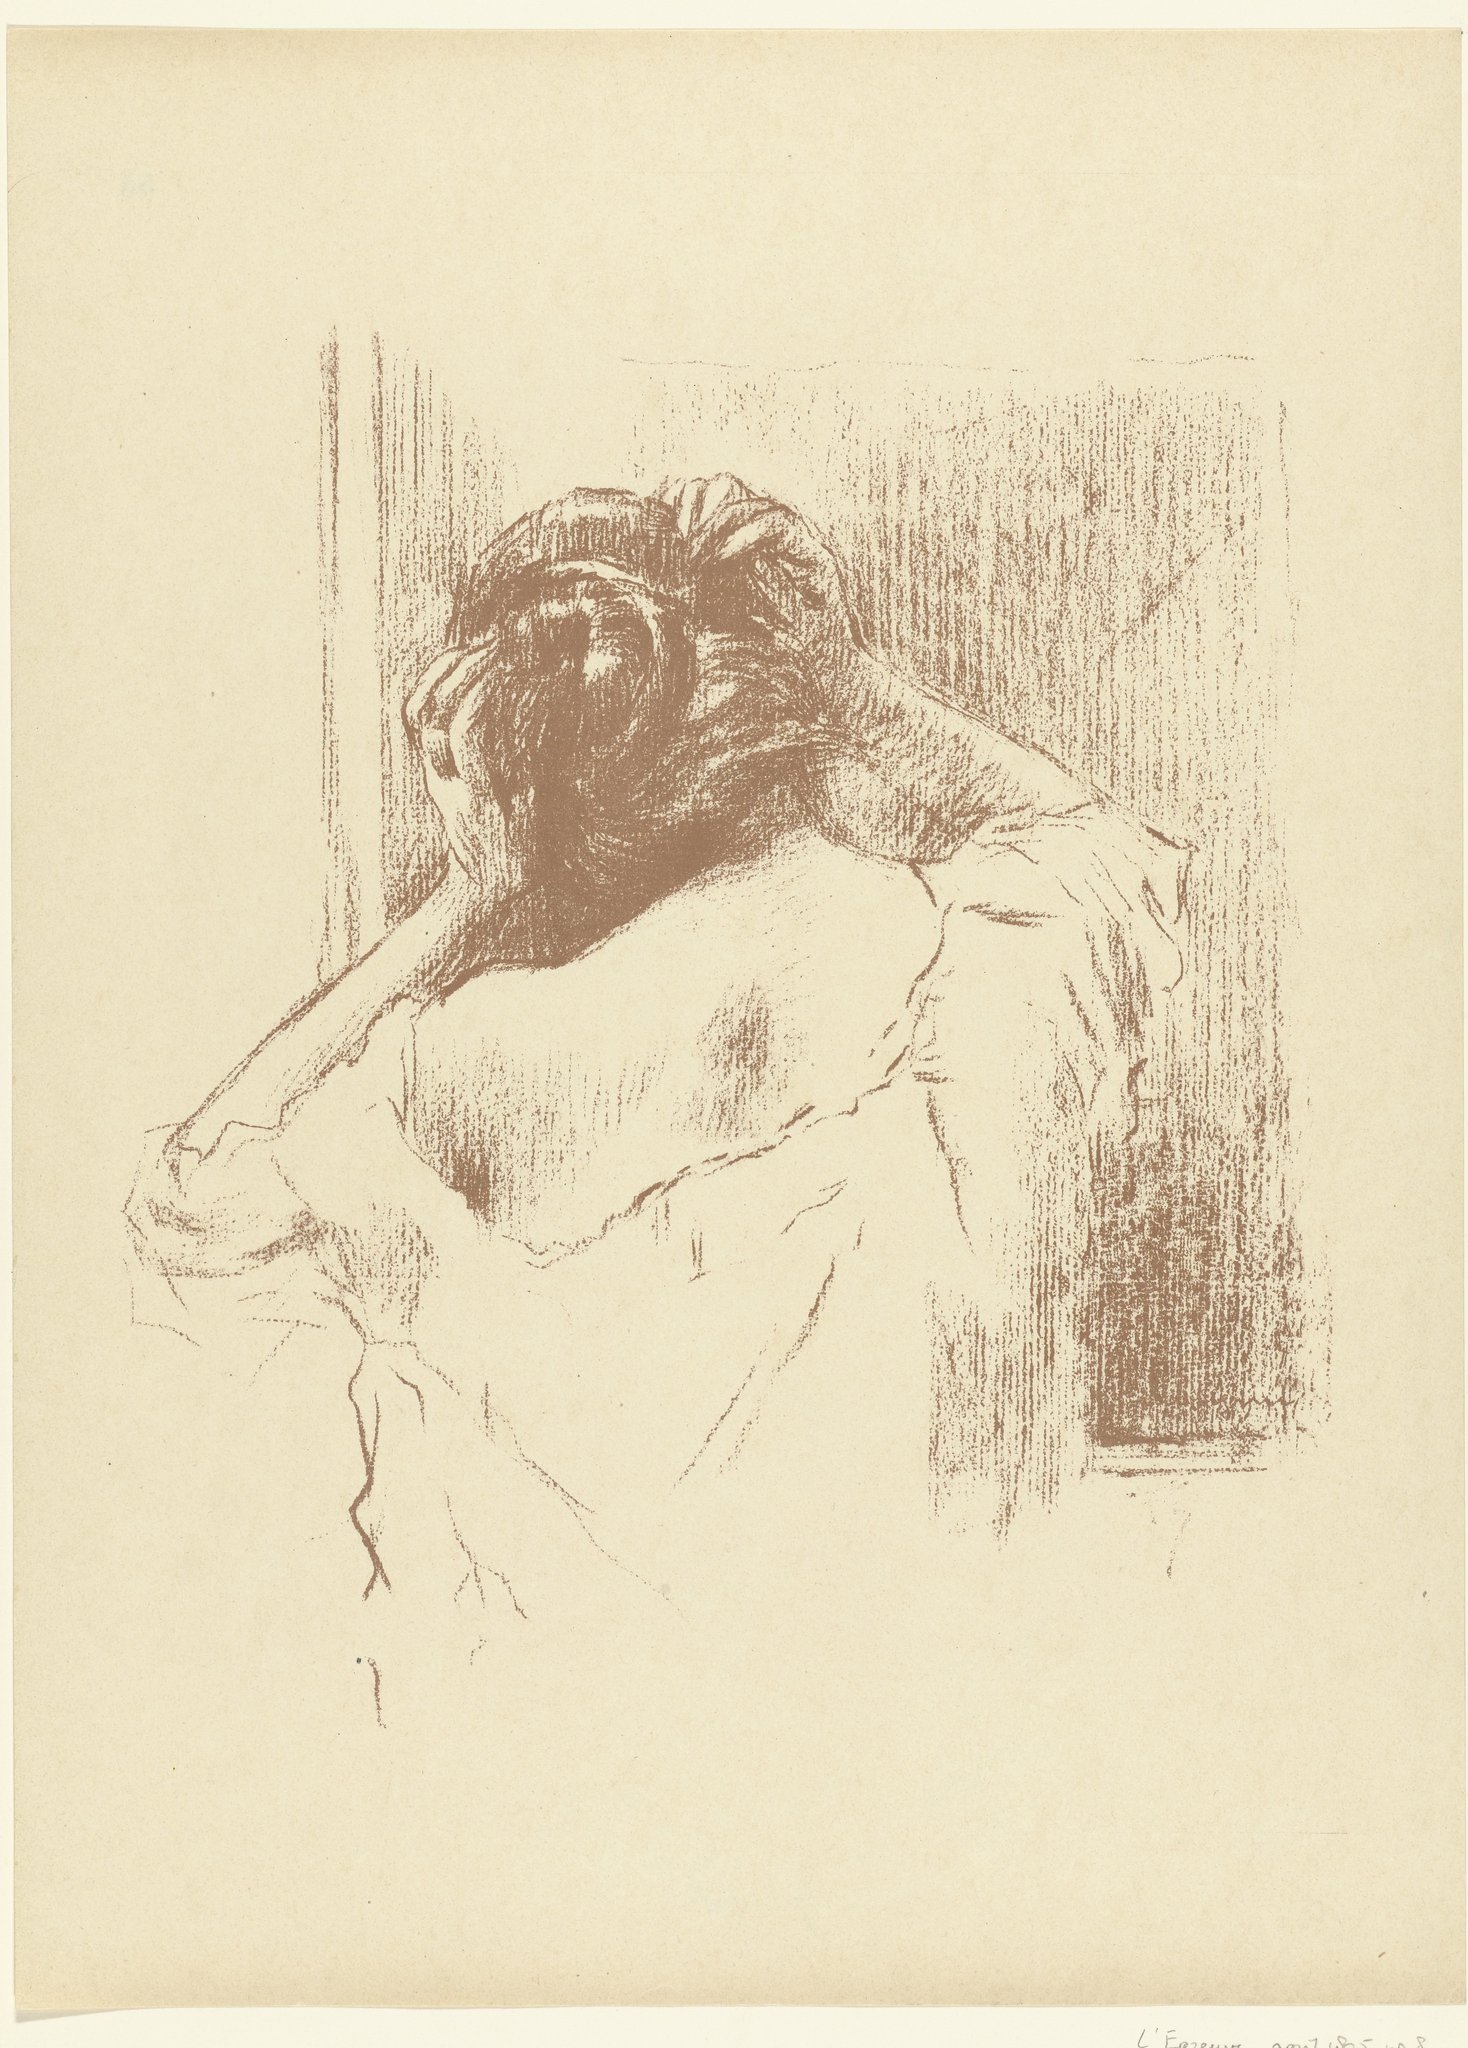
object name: print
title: Vrouw voor spiegel steekt haar op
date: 1804-1895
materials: paper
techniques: printing, lithograph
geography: paris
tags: making toilet, mirror, female sex; woman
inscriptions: collector's mark: Lugt 2228, collector's mark: Lugt 2760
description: Verschenen in album met tien originele prenten als supplement bij tijdschrift: L'Epreuve, april 1895, prent nr. 8